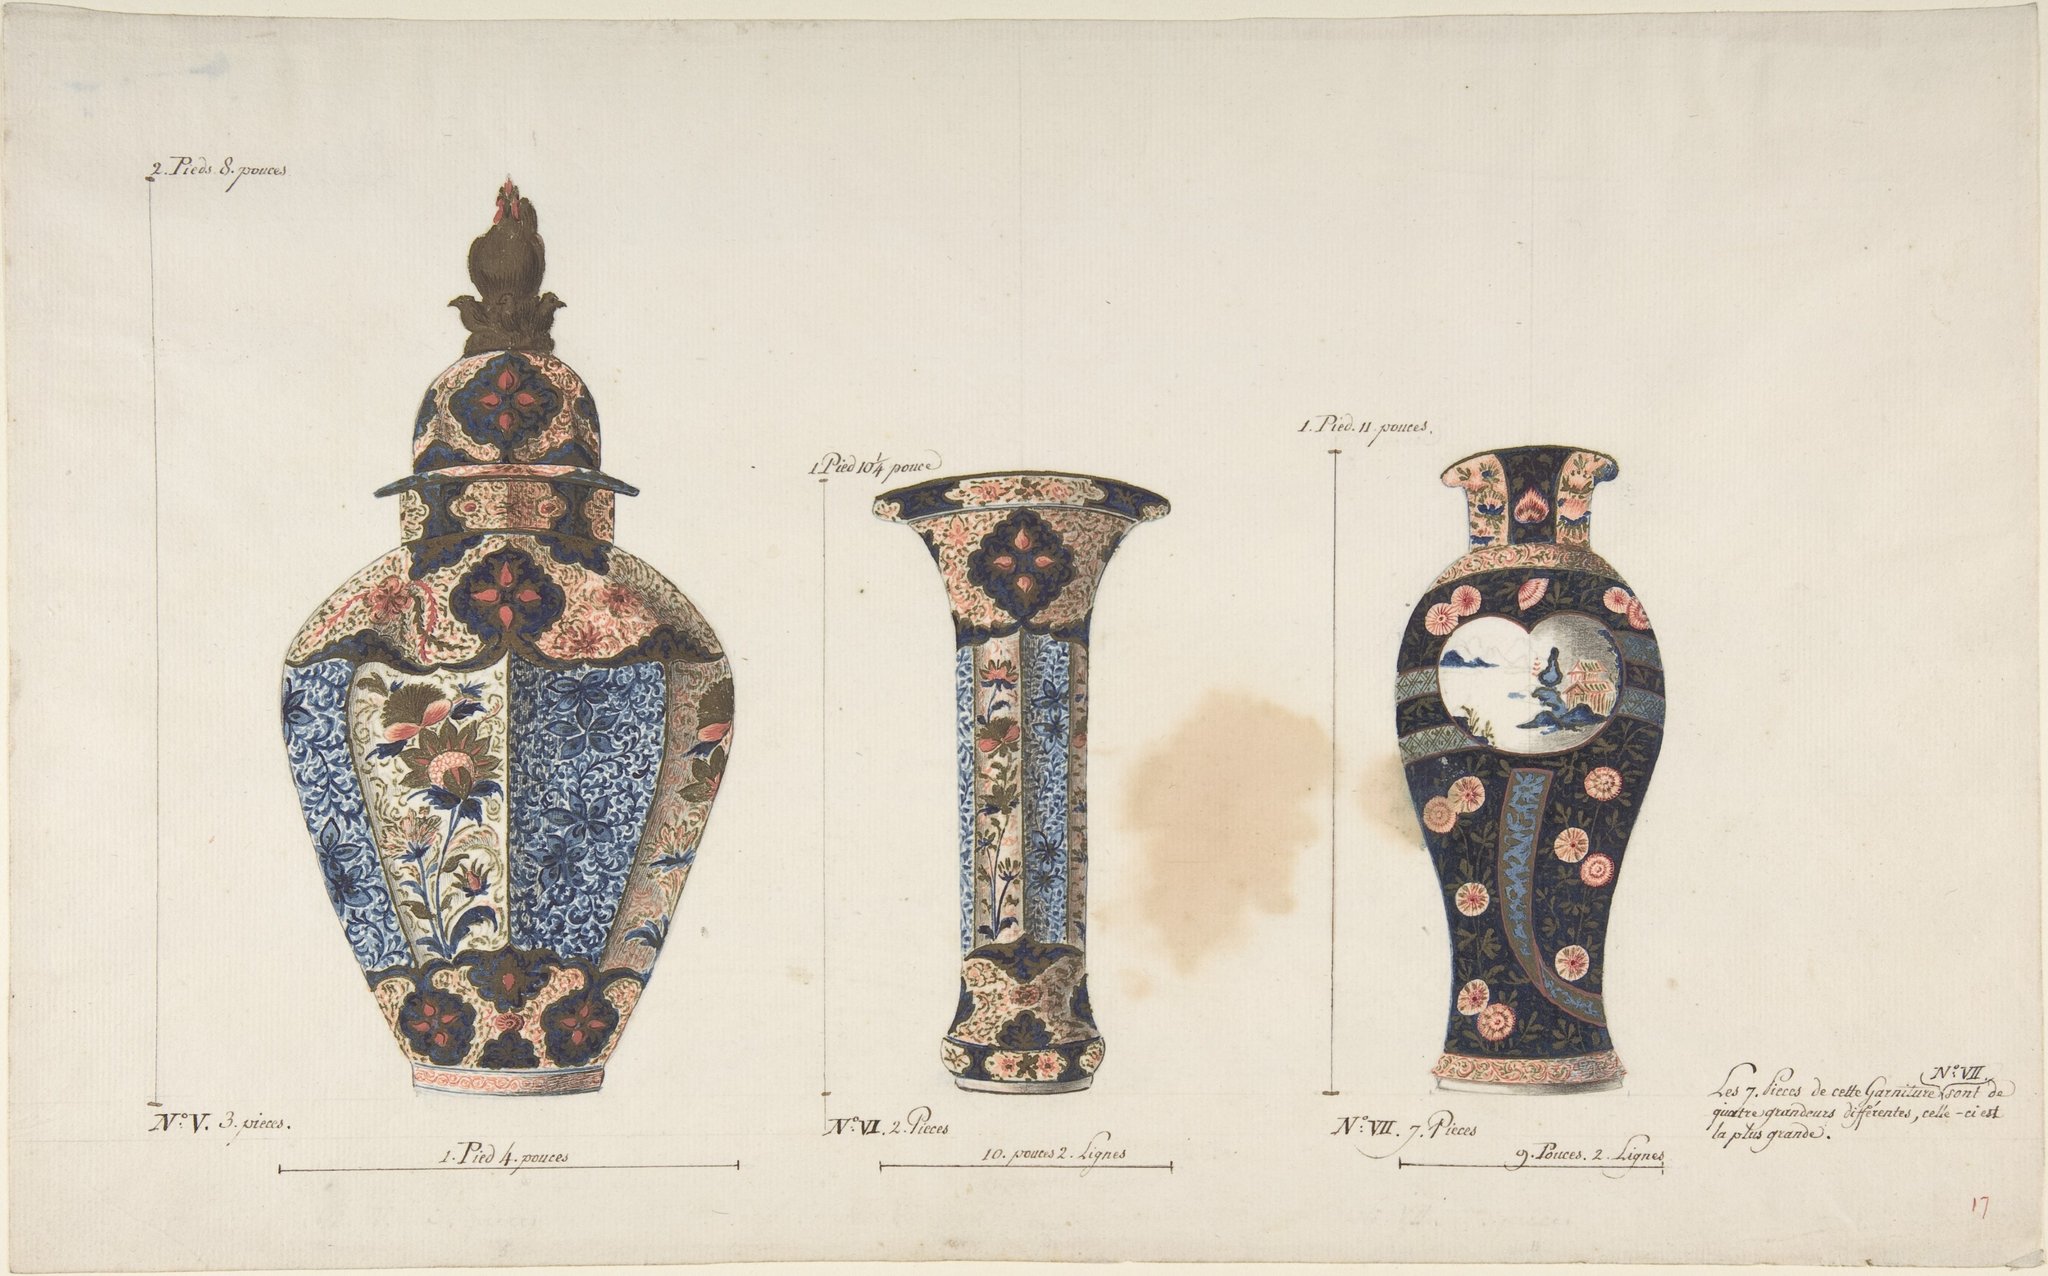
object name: drawing ornament architecture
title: Design for Three Vases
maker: anonymous, french, 18th century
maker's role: artist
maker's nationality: french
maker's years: 1700-1800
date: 1770-1785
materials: graphite, ink, watercolor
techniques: pen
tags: flowers,vases